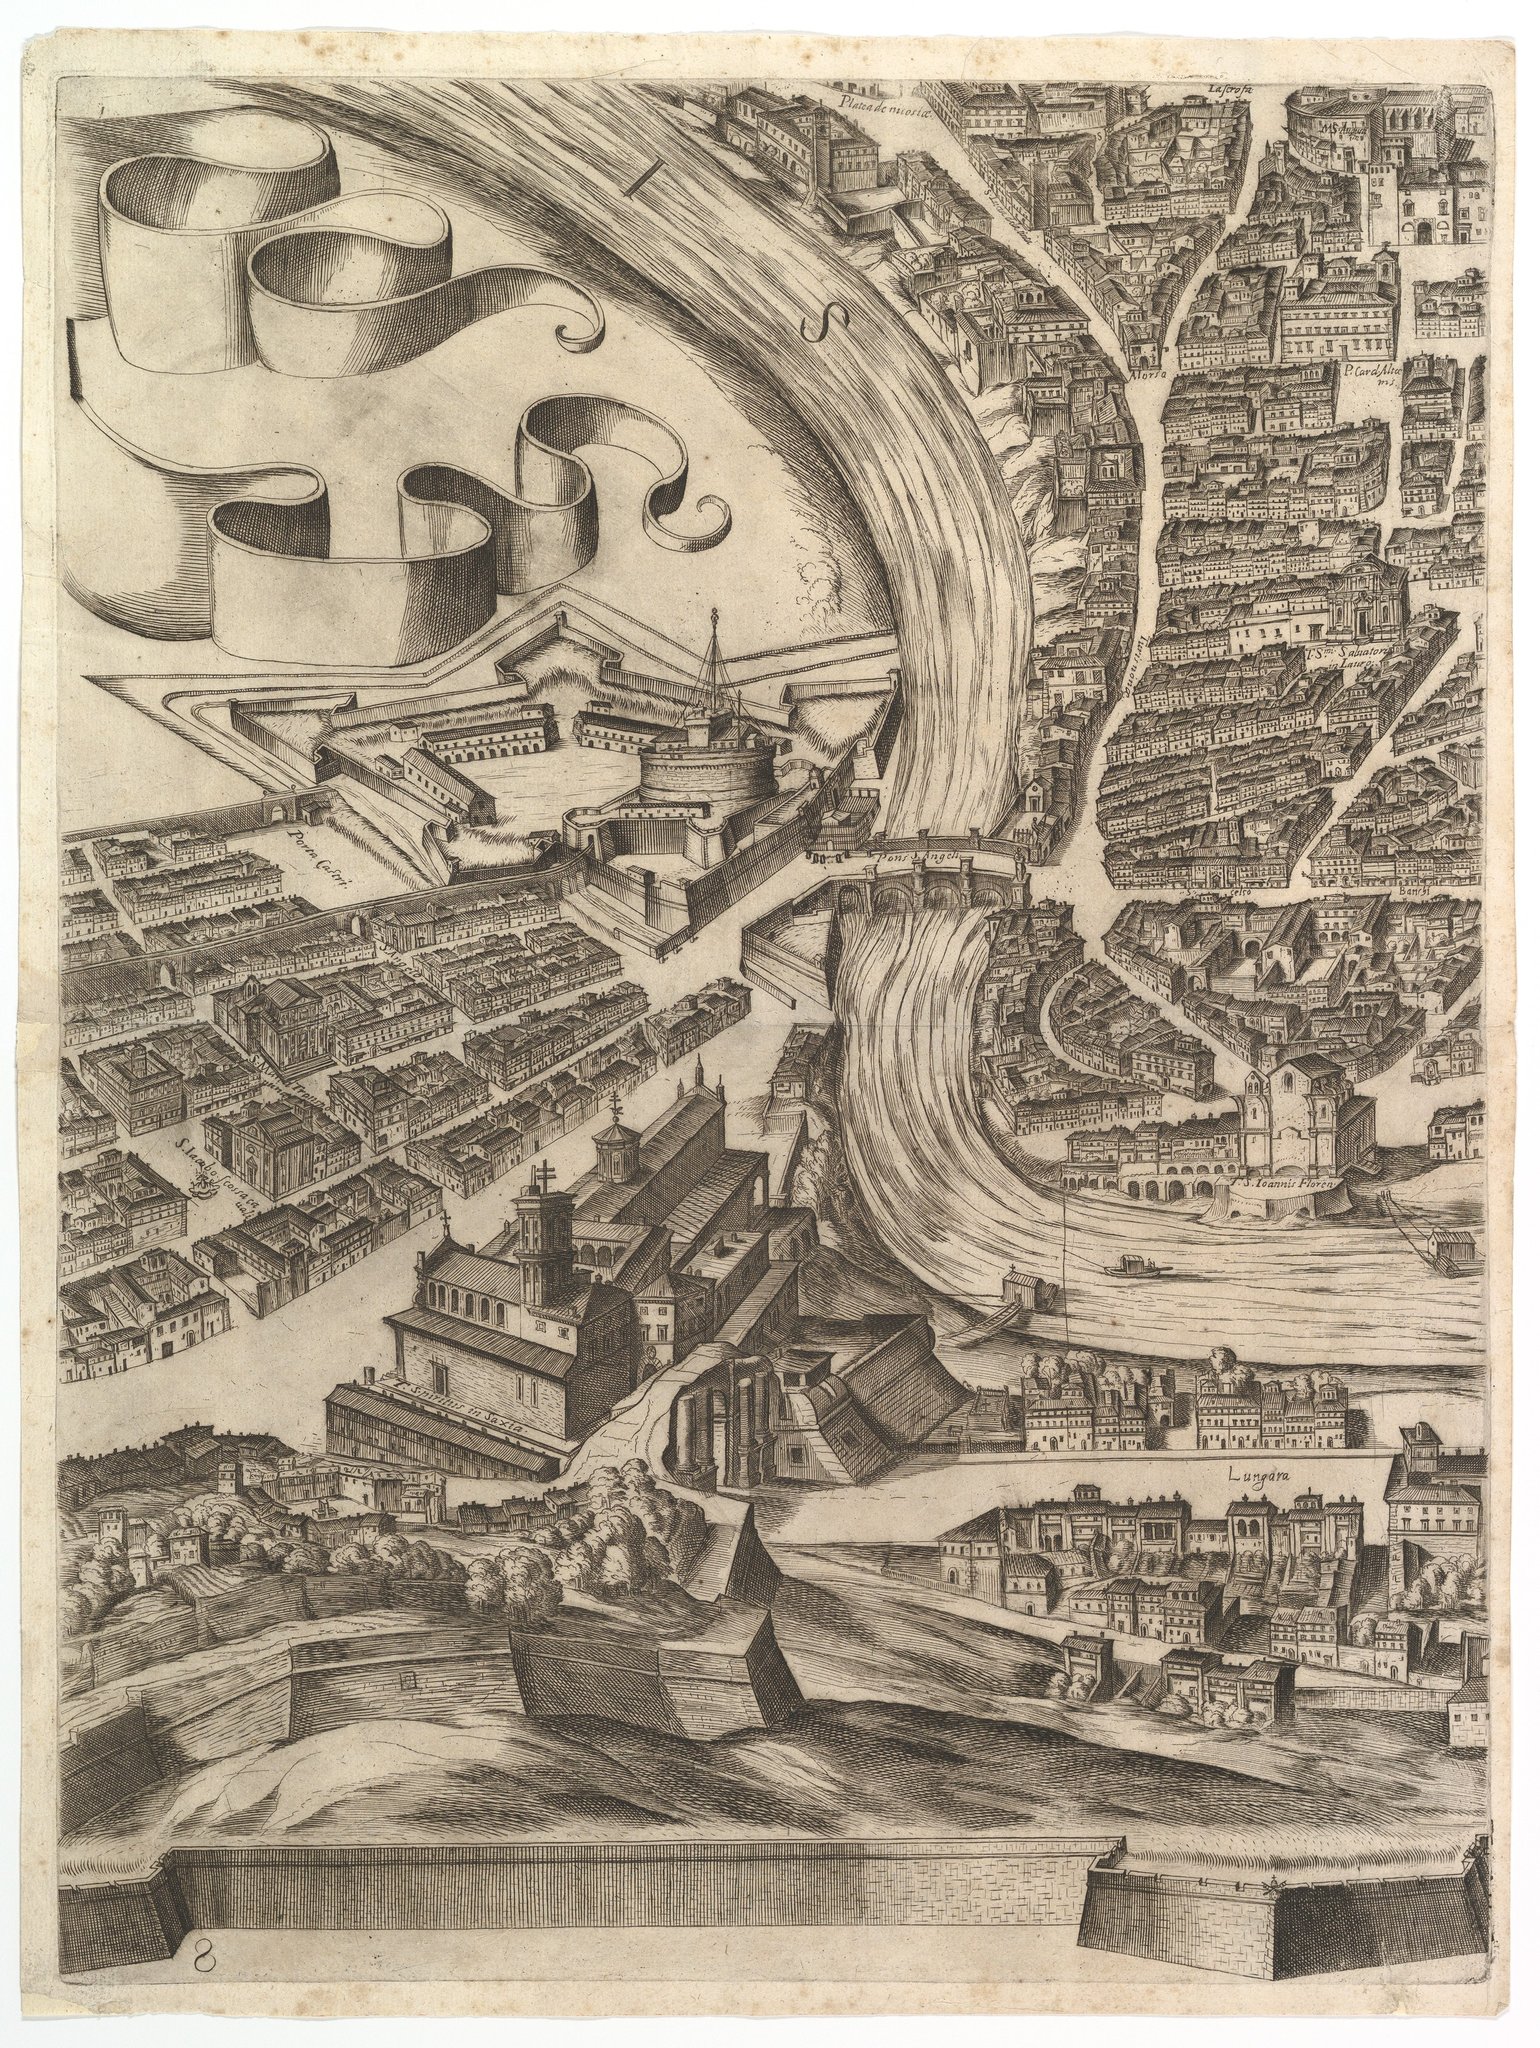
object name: print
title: Plan of the City of Rome. Part 8 with the Castel Sant'Angelo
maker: antonio tempesta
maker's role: artist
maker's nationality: italian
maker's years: 1555-1630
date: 1645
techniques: engraving, etching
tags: cities,maps,rome